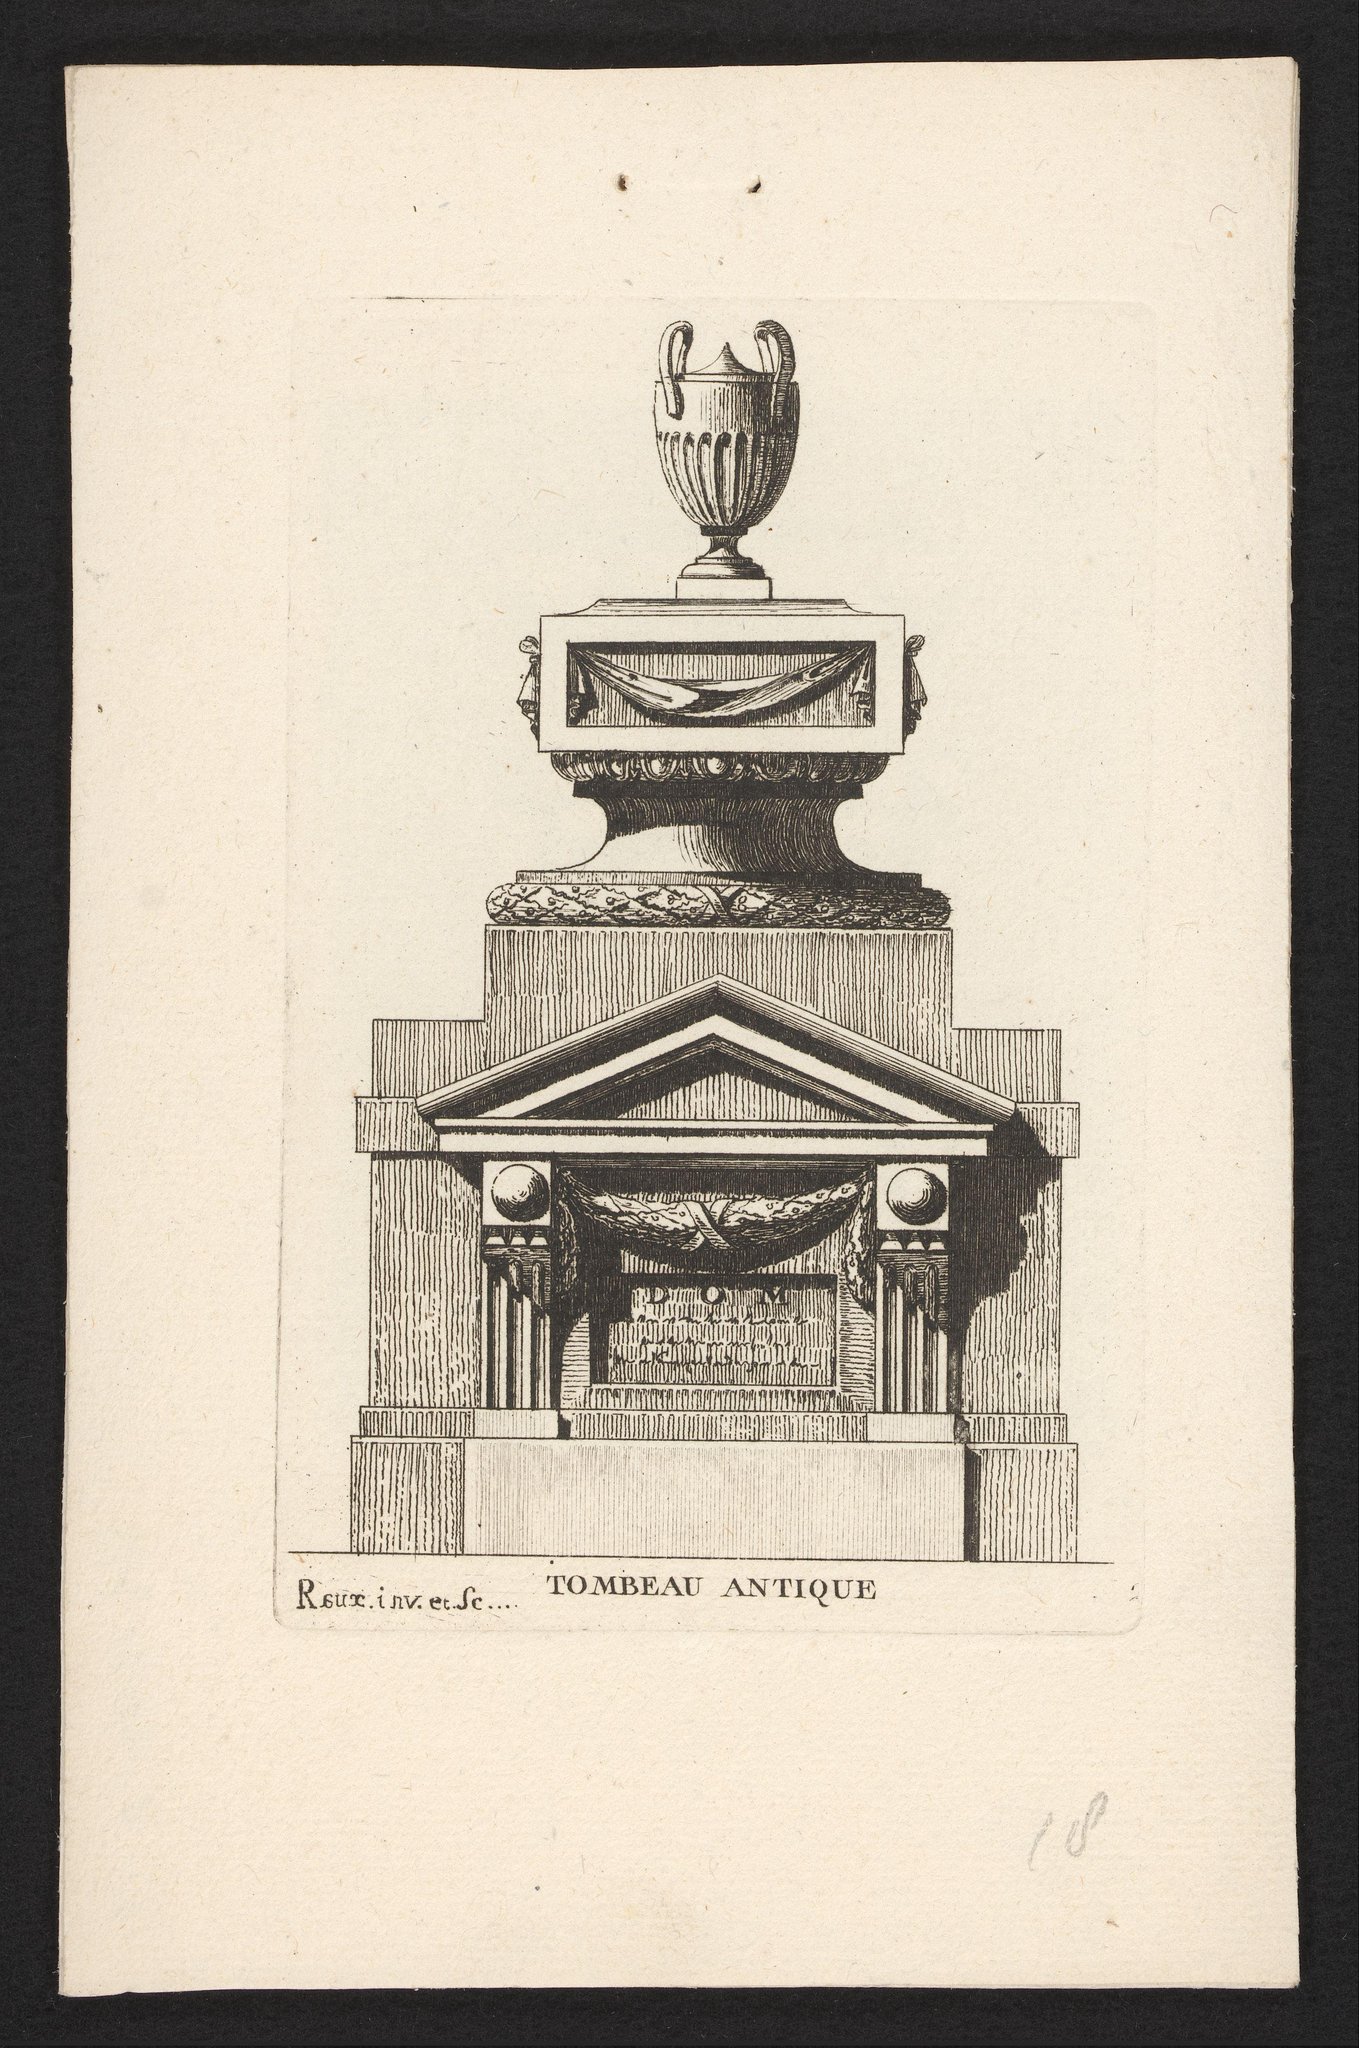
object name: ornament print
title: Grafmonument met vaas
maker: raux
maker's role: print maker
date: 1758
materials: paper, fiber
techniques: etching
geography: france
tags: vase ~ ornament, grave-building, monumental tomb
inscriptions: collector's mark: Lugt 2228, collector's mark: Lugt 2760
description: Een grafmonument met driehoekig fronton en guirlande. Aan de bovenzijde een vaas.